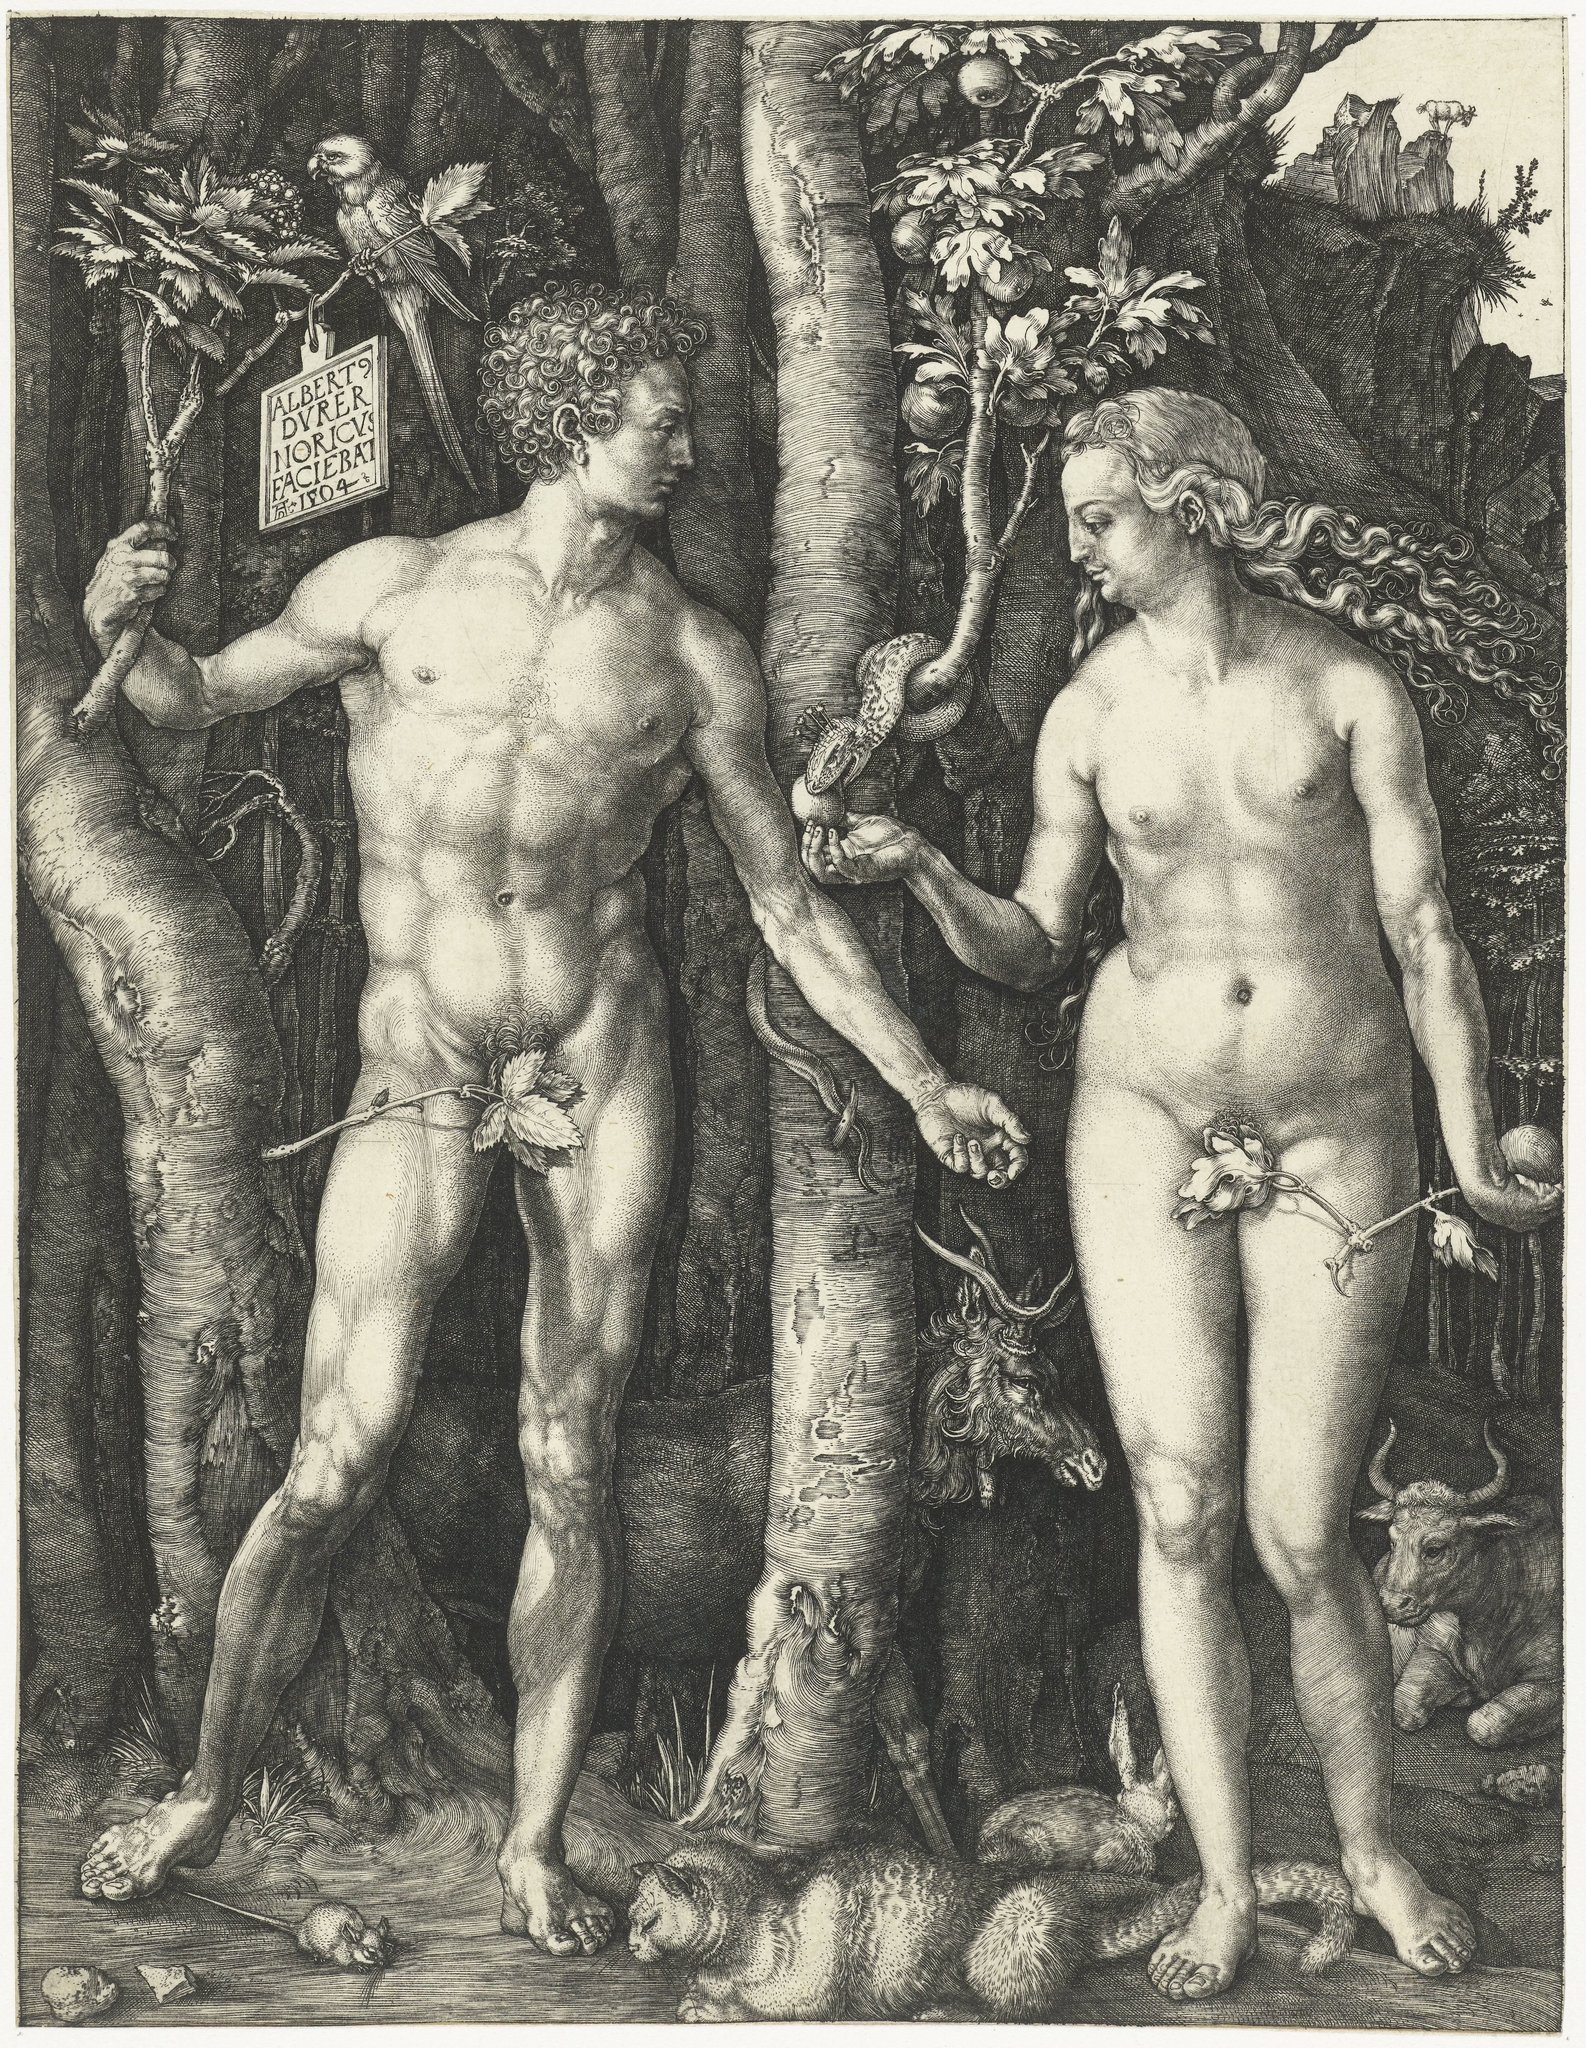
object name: print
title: Adam en Eva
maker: albrecht dürer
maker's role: draughtsman, painter, print maker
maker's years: 1471-1528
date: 1504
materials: paper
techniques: engraving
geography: nuremberg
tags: eve takes the fruit from the serpent (or the tree) in the presence of adam (who may be trying to stop her)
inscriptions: signature and date: ‘ALBERT/ DVRER/ NORICVS/ FACIEBAT/ AD 1504’, collector's mark: Lugt 240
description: Mogelijk had deze prent oorspronkelijk het inventarisnummer RP-P-1877-A-20 (zie opmerking aldaar). Klinkert, C.